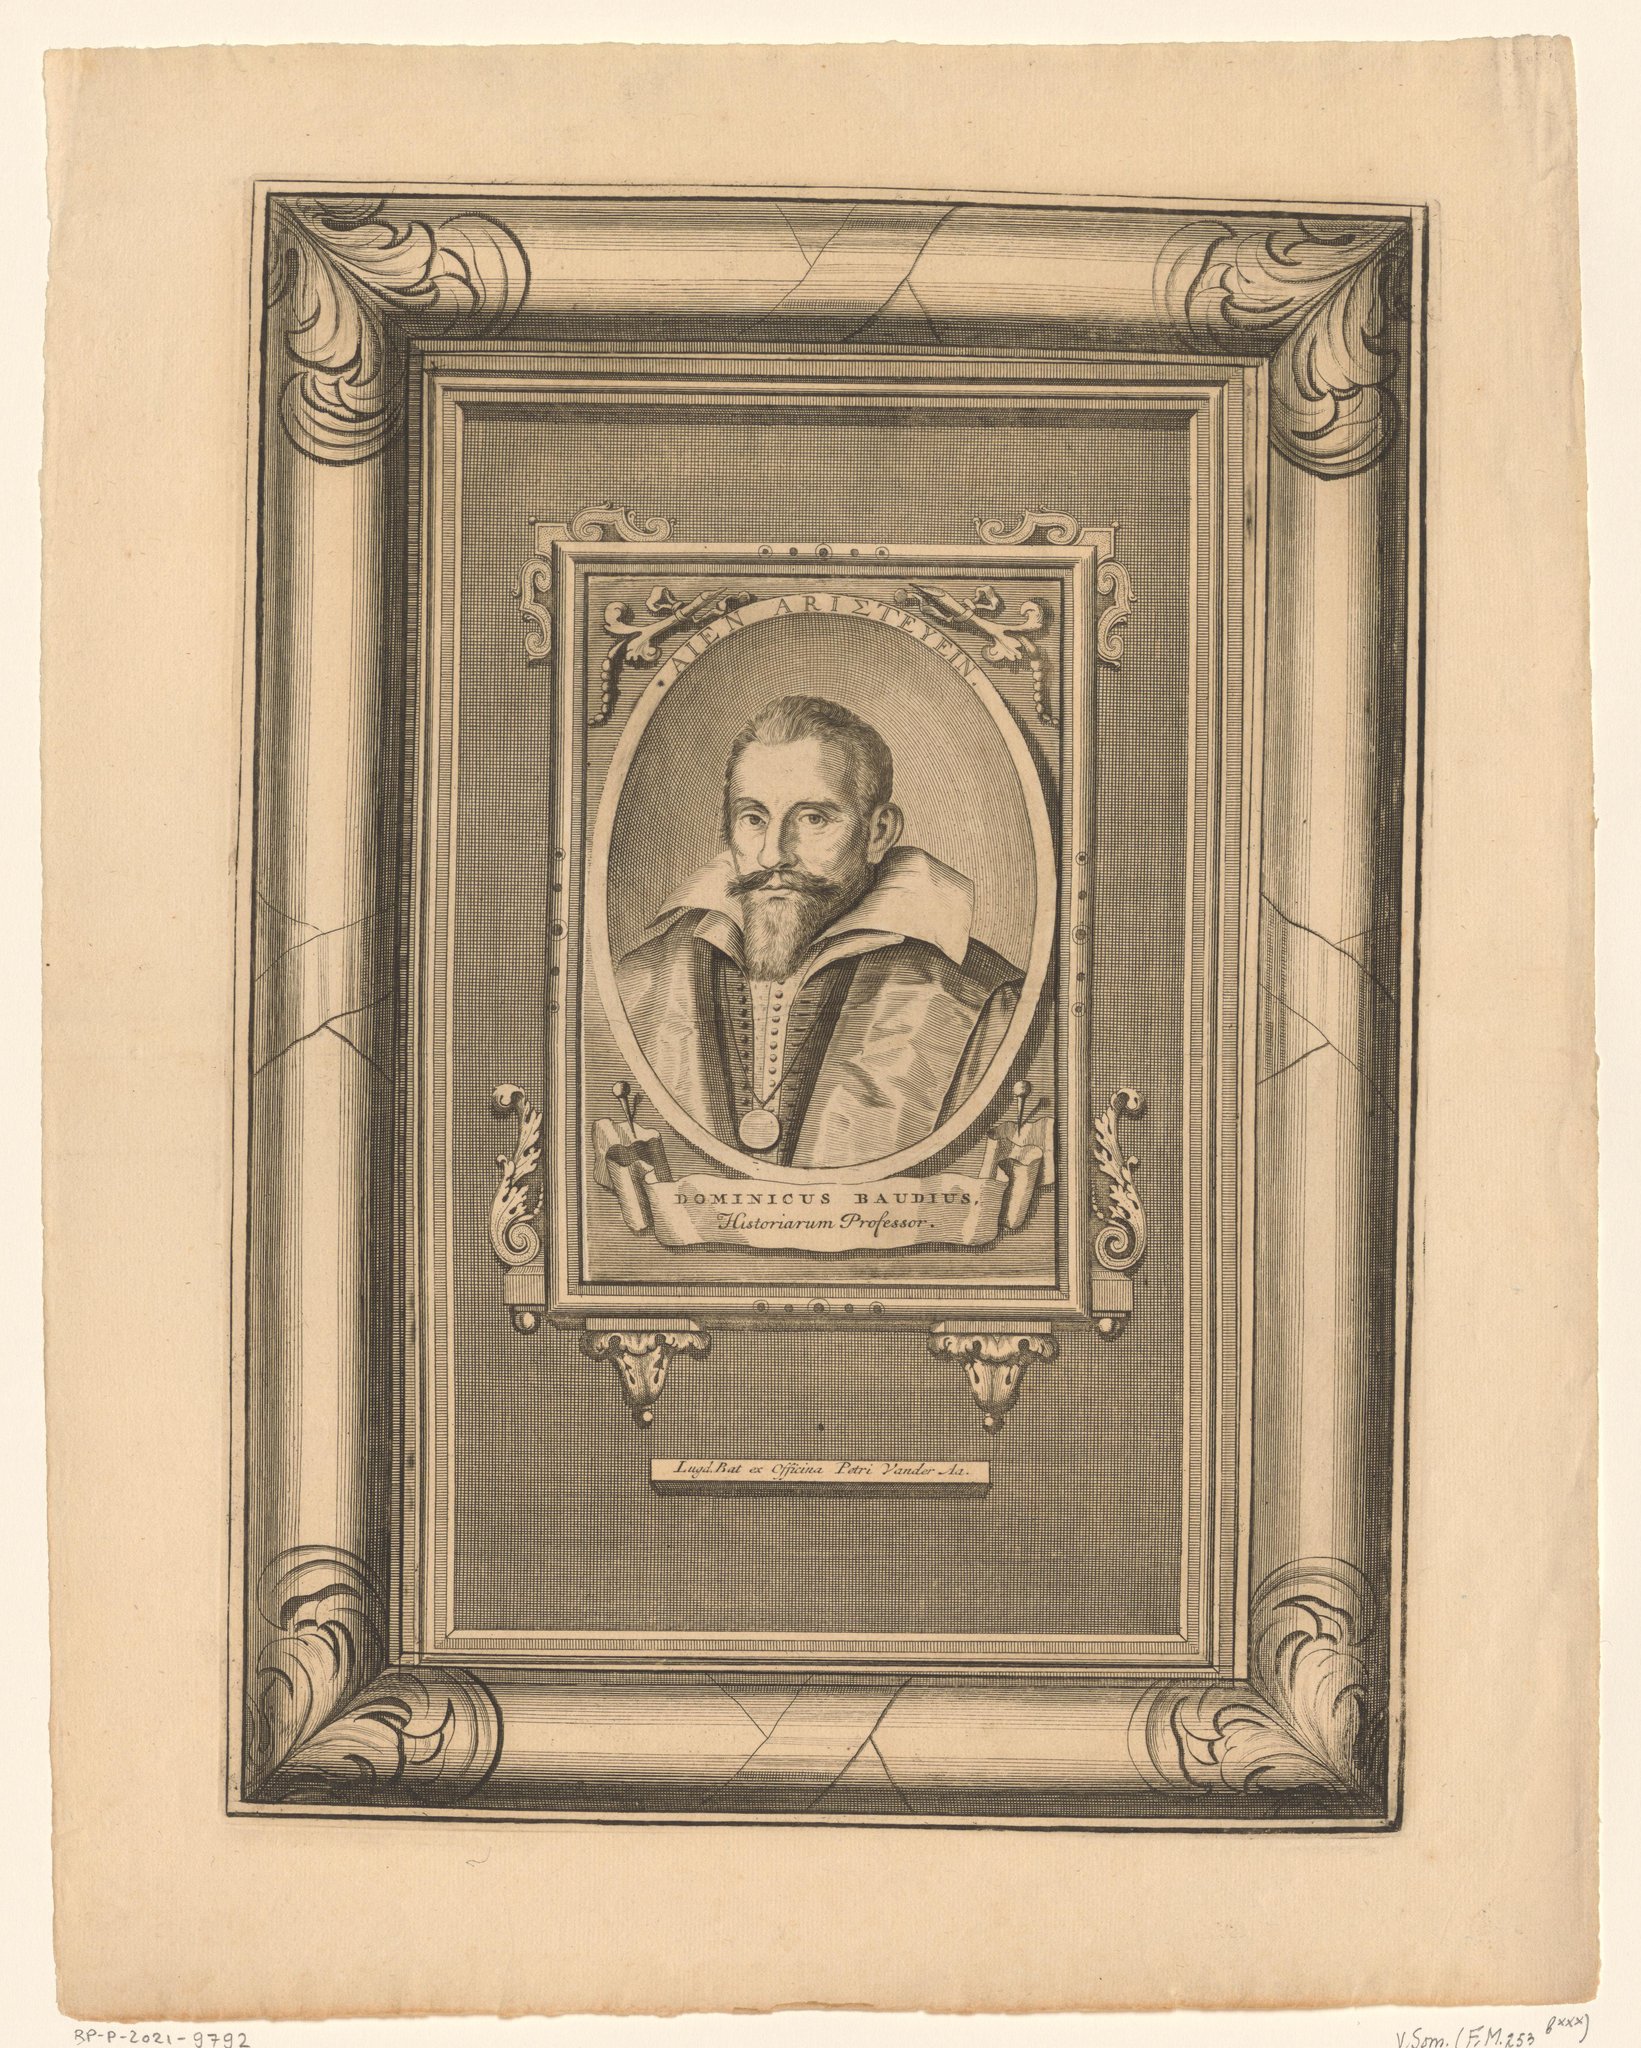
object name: print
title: Dominicus Baudius, Historiarum Professor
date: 1668-1733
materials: paper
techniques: engraving, etching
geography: leiden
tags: lille, leiden, dominicus baudius, historical persons, professor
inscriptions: collector's mark: Lugt 2228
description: Prent met enkele omlijsting gebruikt in: Fundatoris, curatorum et professorum celeberrimorum (...). Leiden: Pieter van der Aa, 1716.